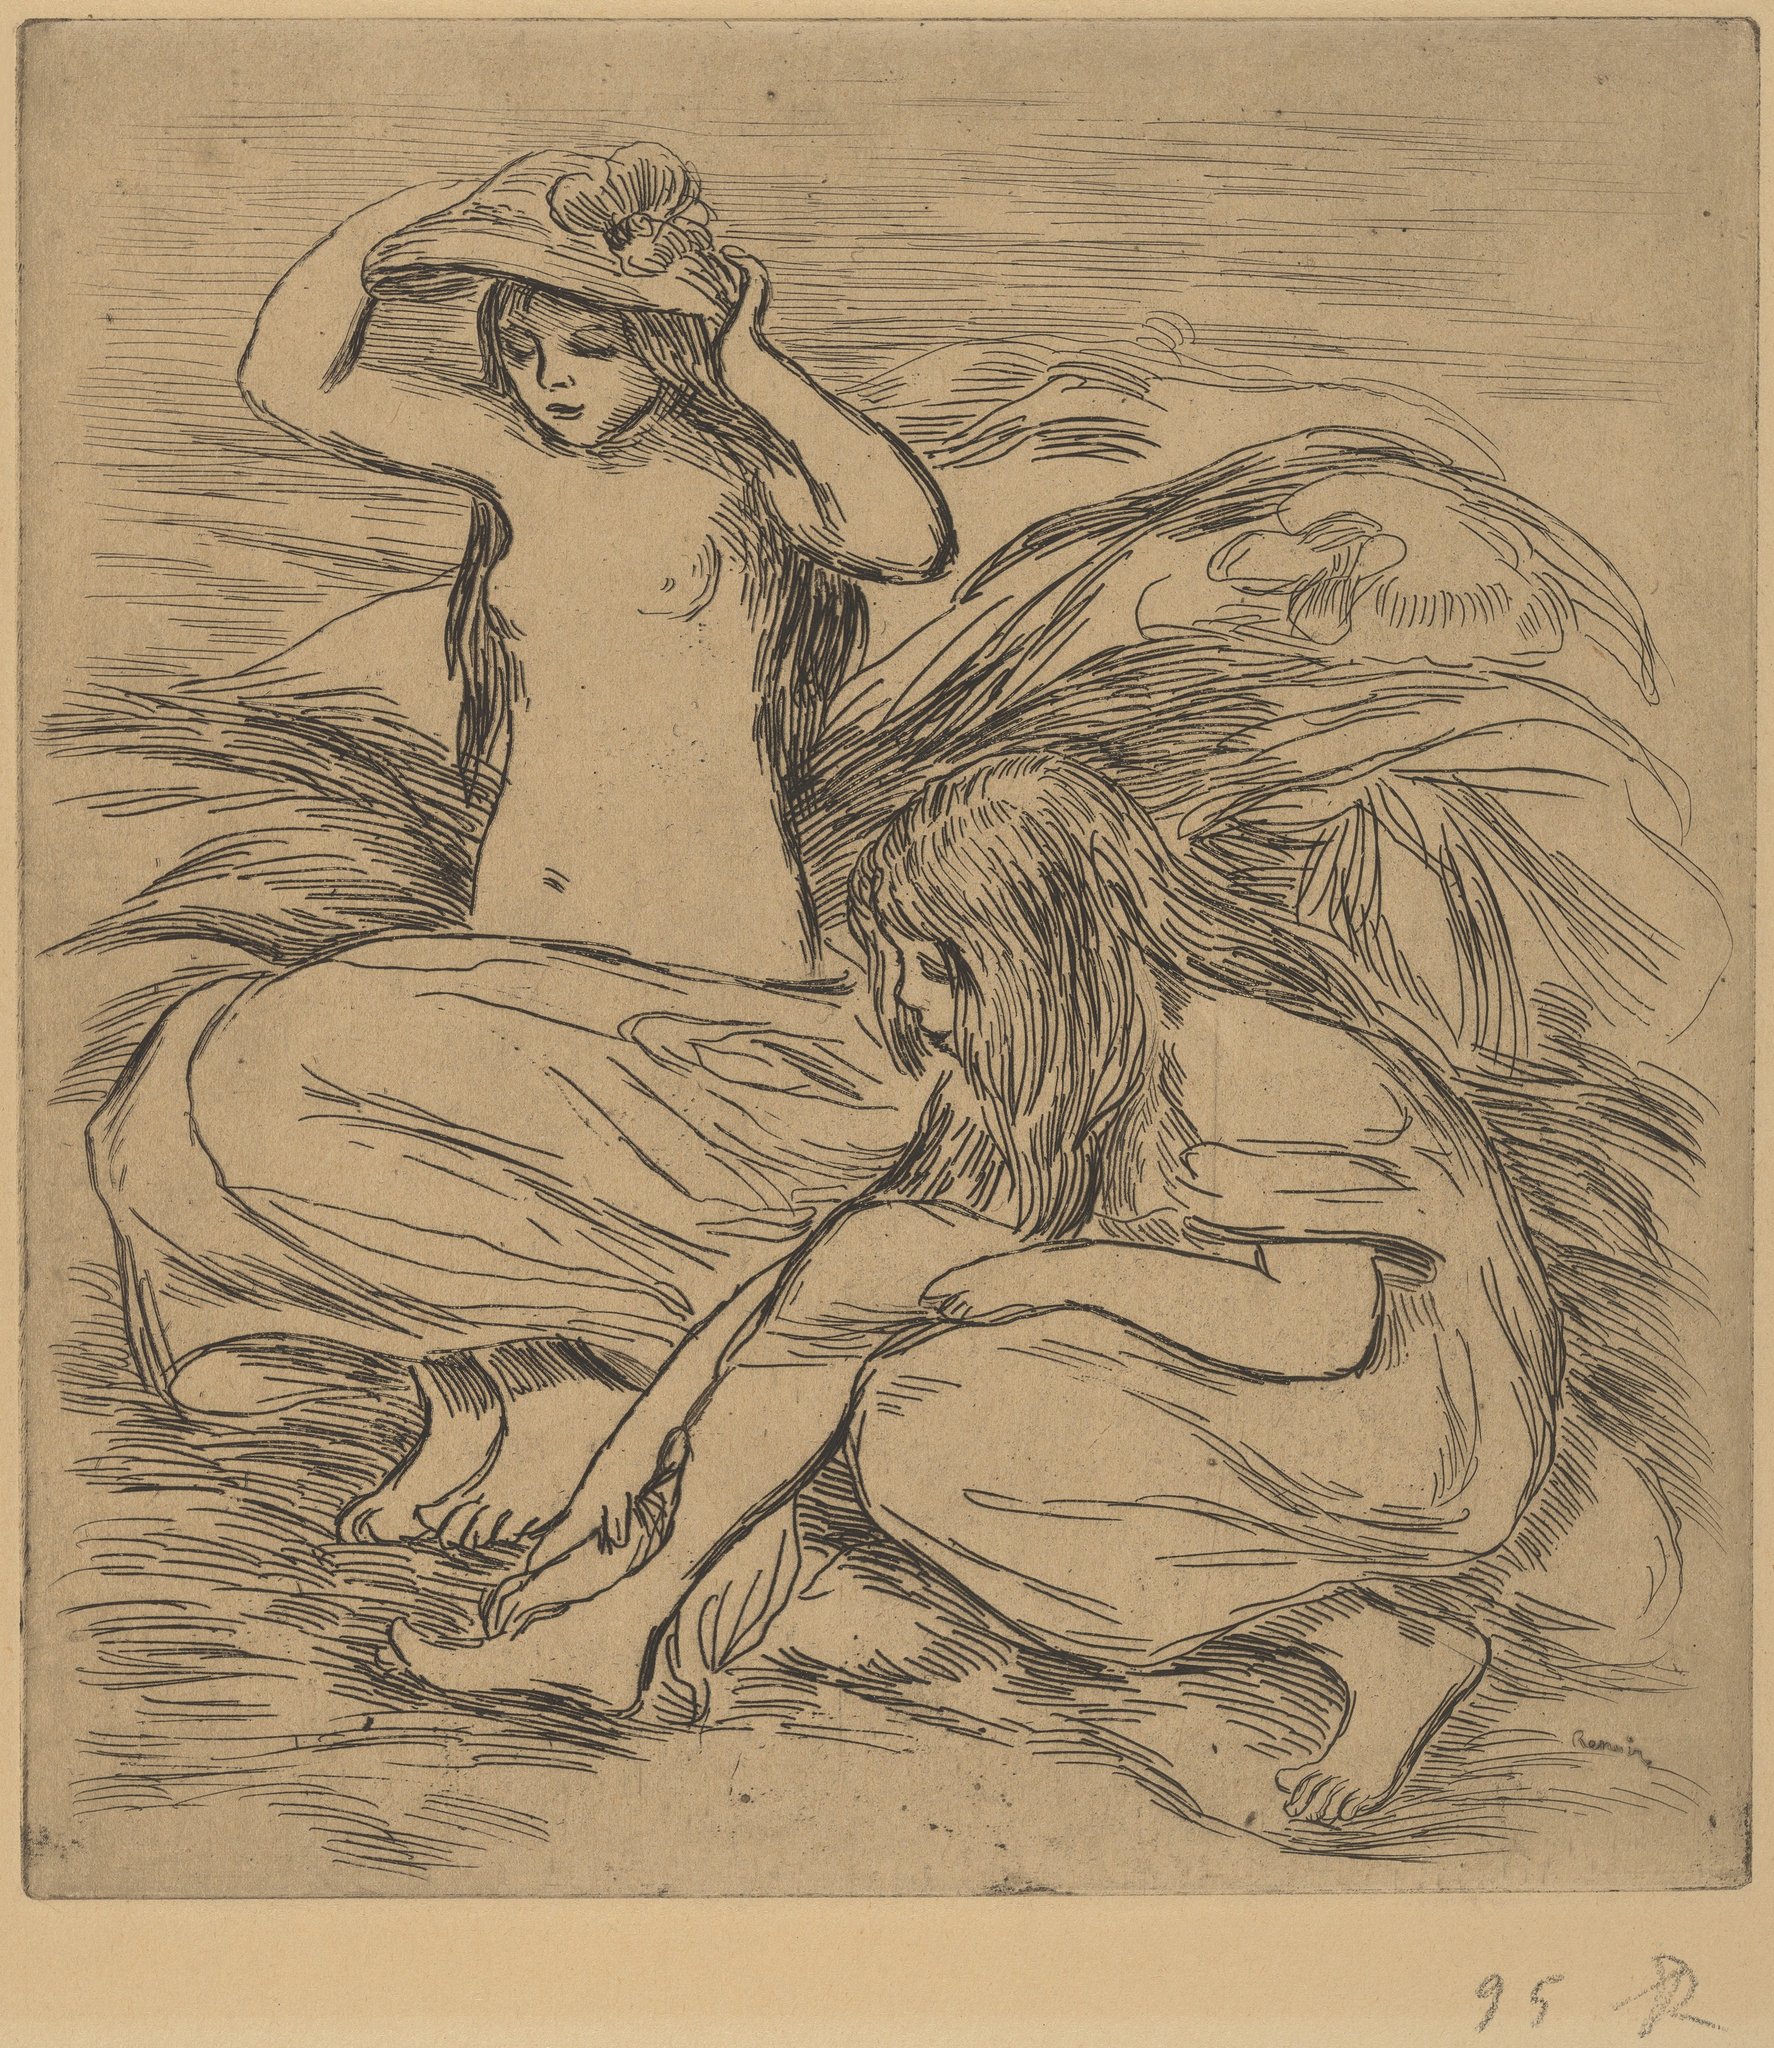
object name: print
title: The Two Bathers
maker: pierre auguste renoir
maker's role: artist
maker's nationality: french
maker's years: 1841-1919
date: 1895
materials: paper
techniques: etching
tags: female nudes,bathing